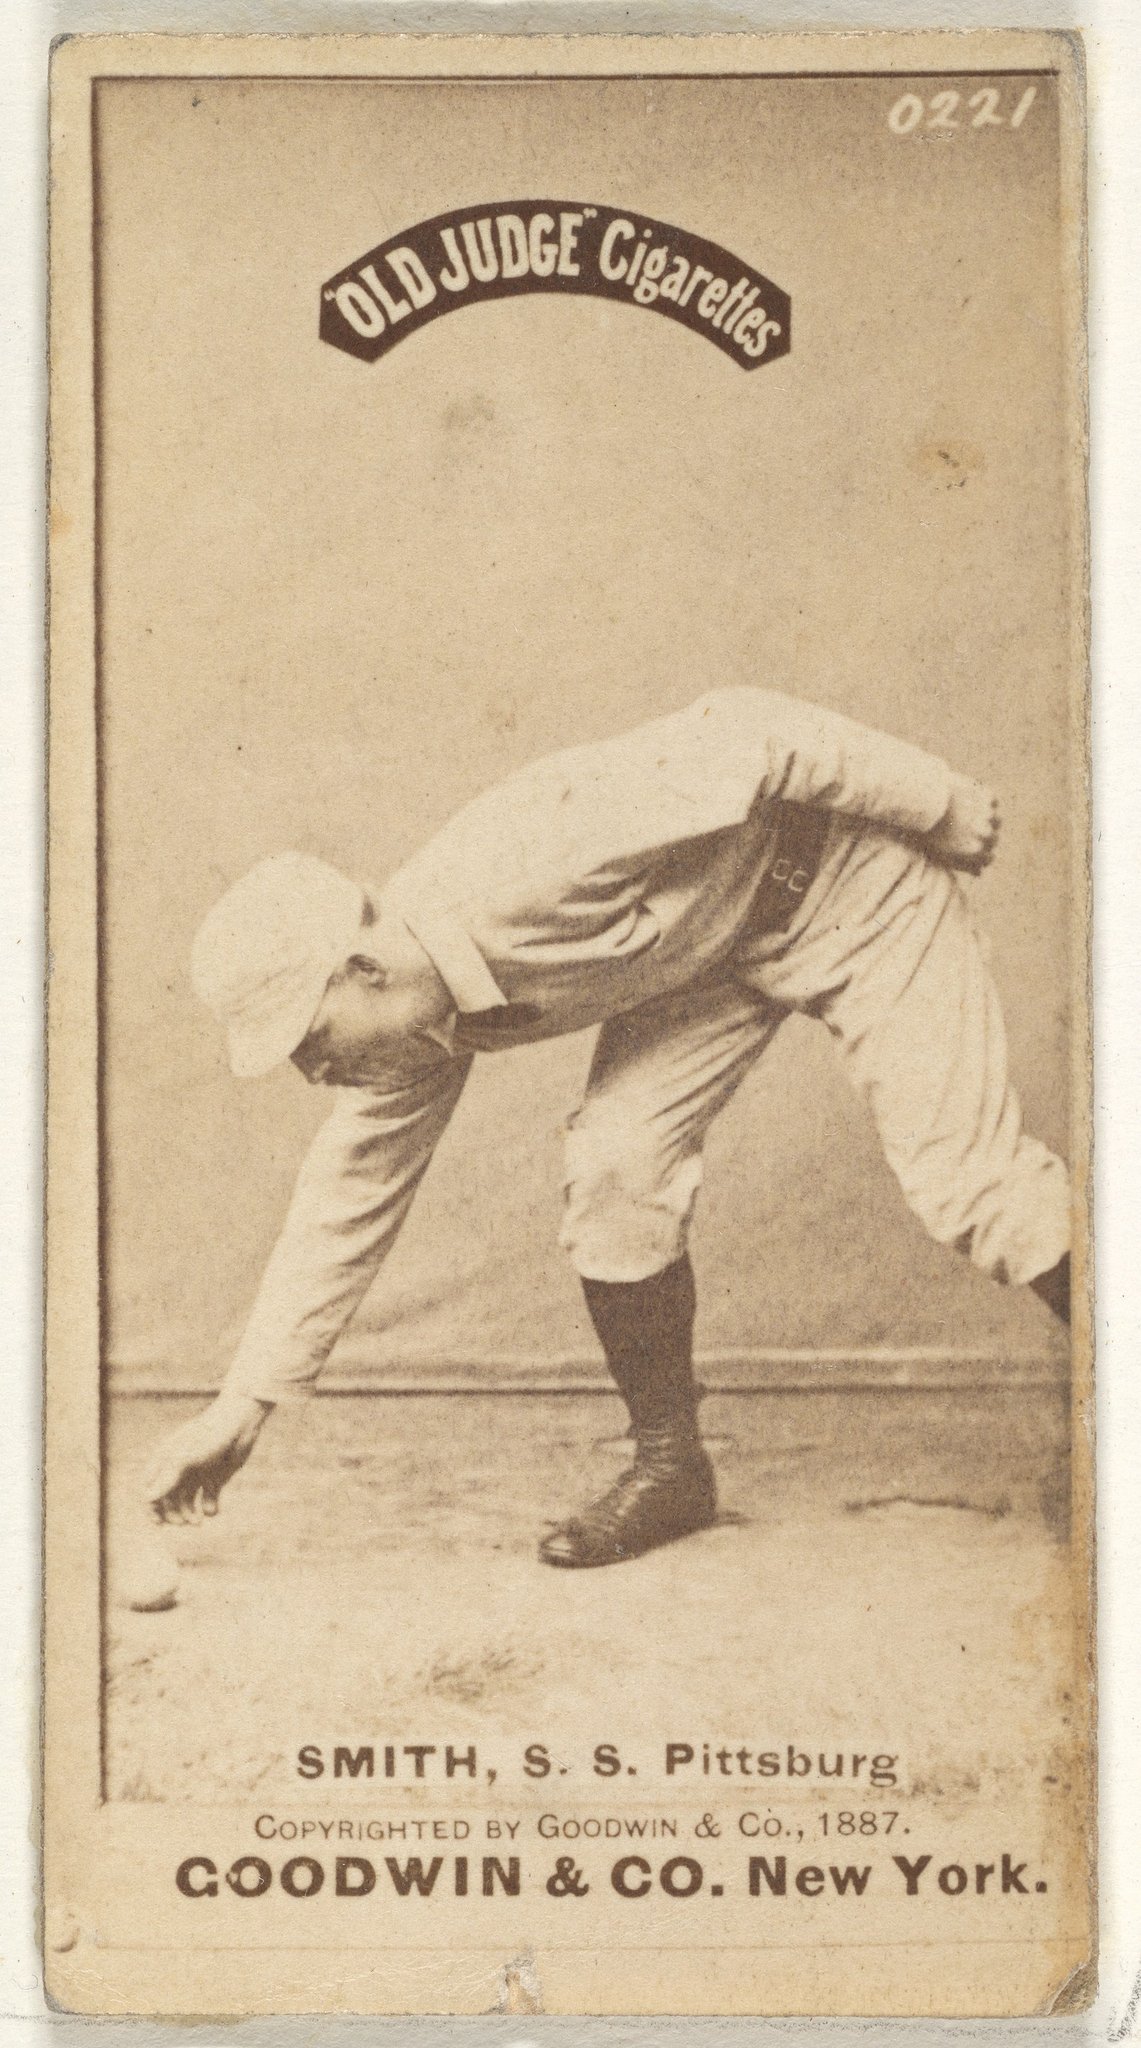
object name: baseball card, photograph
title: Charles Marv "Pop" Smith, Shortstop, Pittsburgh, from the Old Judge series (N172) for Old Judge Cigarettes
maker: goodwin & company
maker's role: publisher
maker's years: 1850-1950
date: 1887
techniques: albumen silver print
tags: men,portraits,baseball,athletes